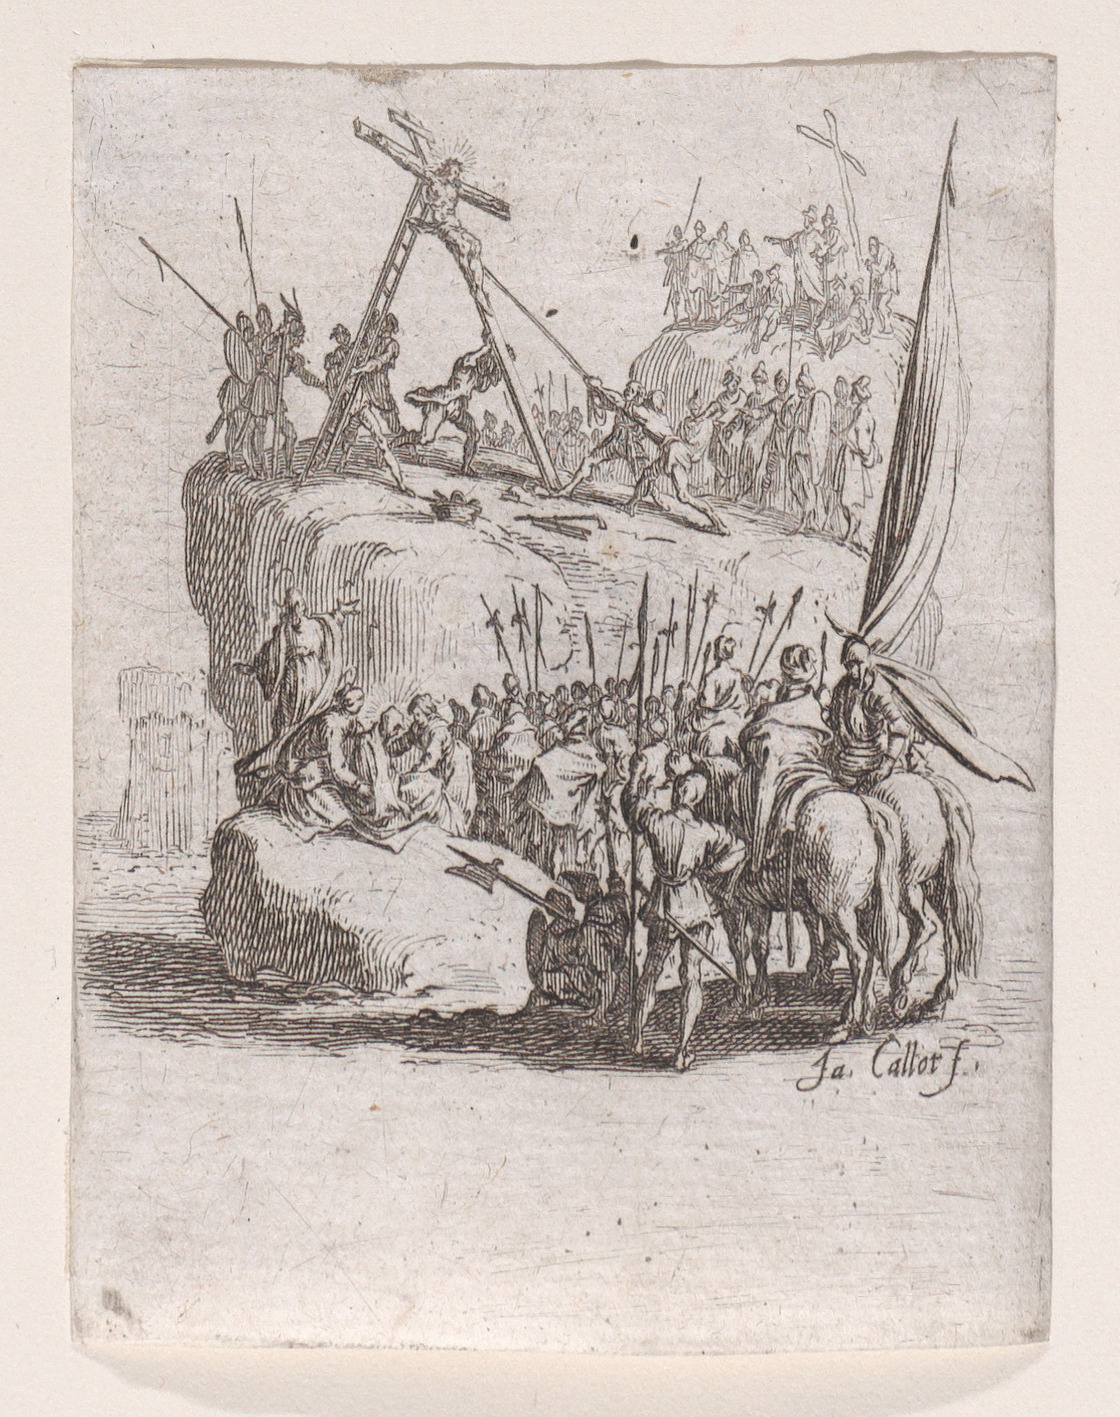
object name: print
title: Le Crucifiement (The Crucifixion), from "La Petite Passion" (The Little Passion)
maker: jacques callot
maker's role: artist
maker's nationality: french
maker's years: 1592-1635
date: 1624-1625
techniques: etching